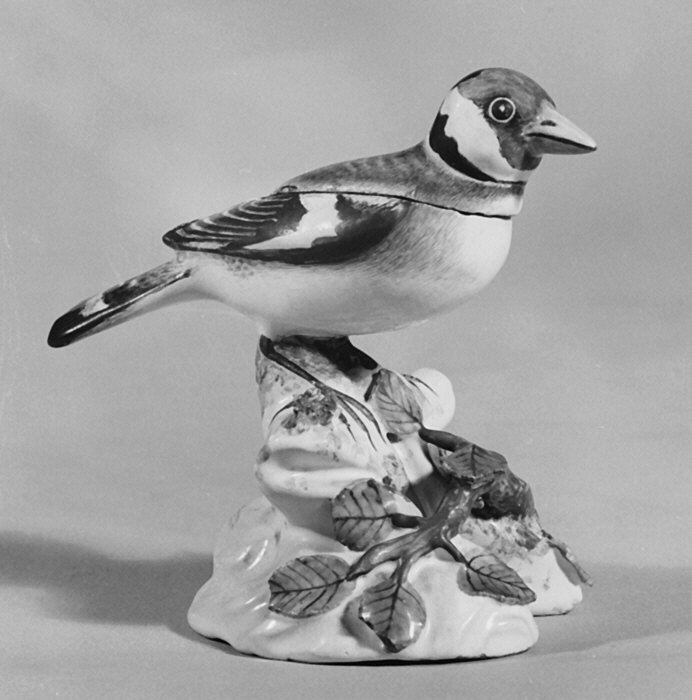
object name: figure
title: Linnet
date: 1750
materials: earthenware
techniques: glazing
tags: birds,leaves